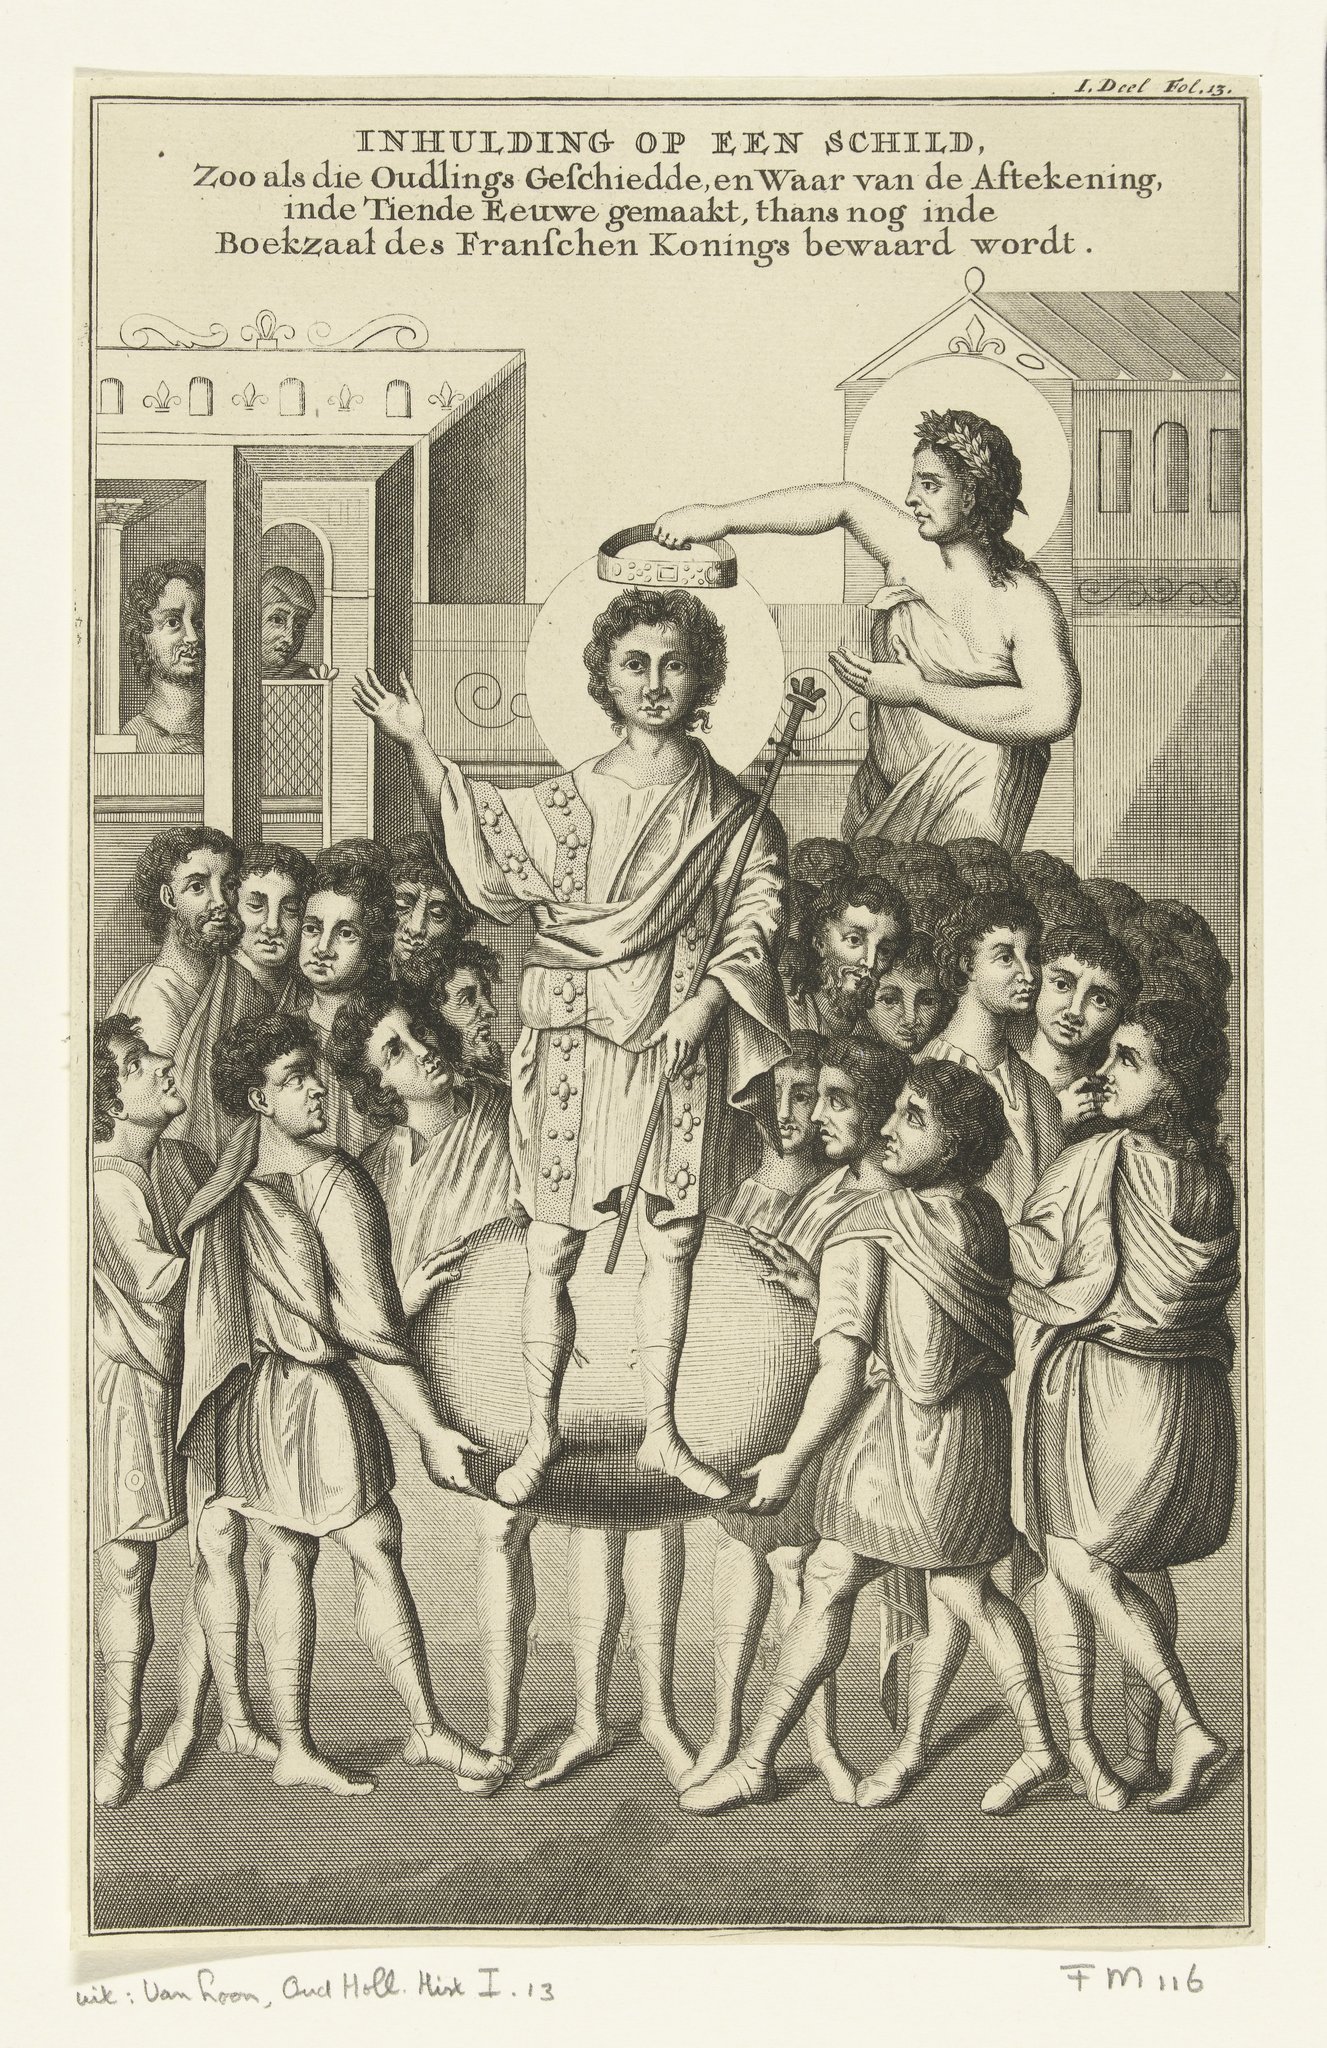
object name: historical object representation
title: Inhuldiging op een schild, naar een 10e eeuwse tekening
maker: Anonymous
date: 1732-1734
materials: paper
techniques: engraving, etching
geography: northern netherlands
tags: drawing, sketch, coronation of a ruler, picture, painting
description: De kroning of inhuldiging van een vorst, staande op een schild. Voorstelling vervaardigd naar het voorbeeld van een 10e eeuwse tekening.